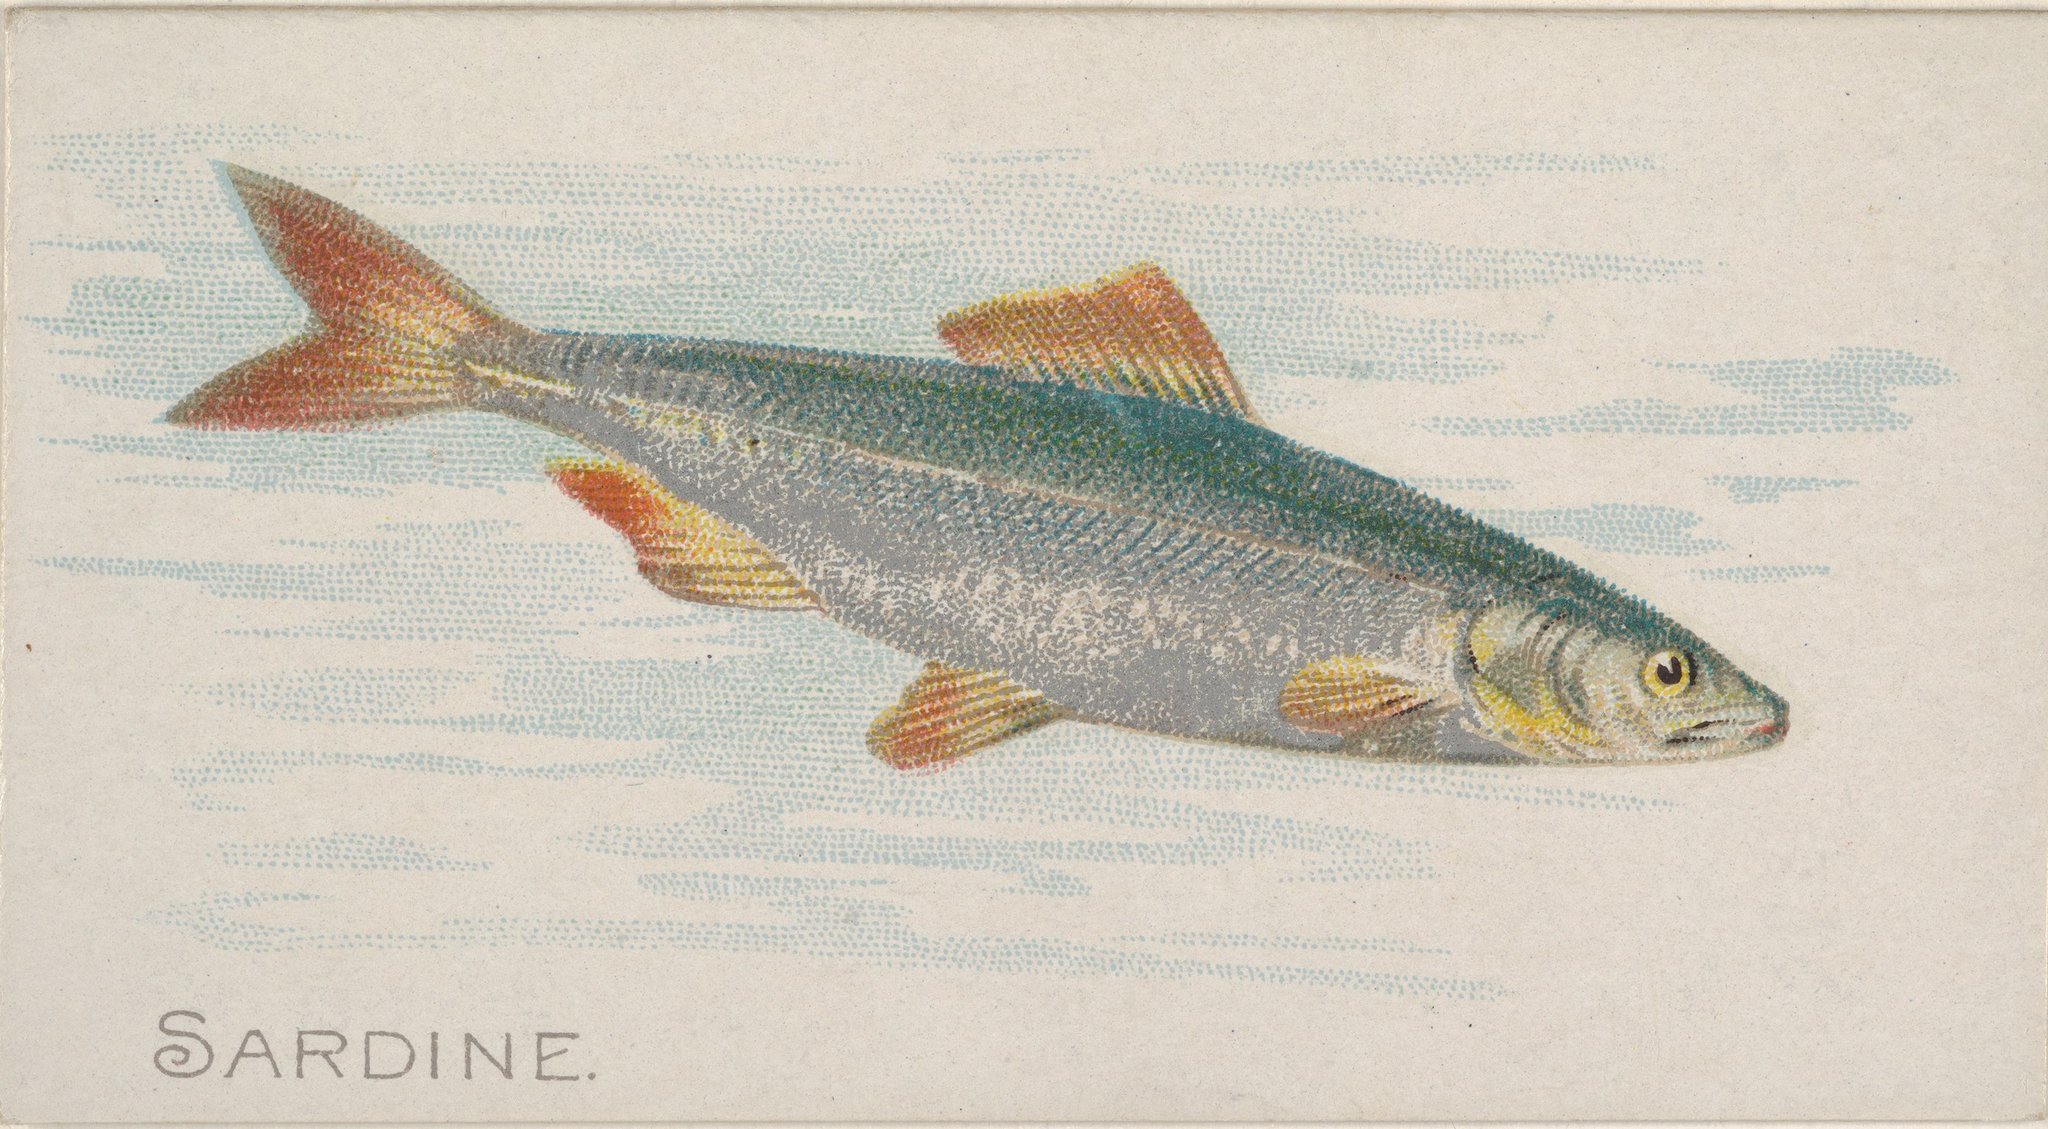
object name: print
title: Sardine, from the Fish from American Waters series (N8) for Allen & Ginter Cigarettes Brands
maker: allen & ginter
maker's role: publisher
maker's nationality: american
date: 1889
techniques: color lithograph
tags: fish